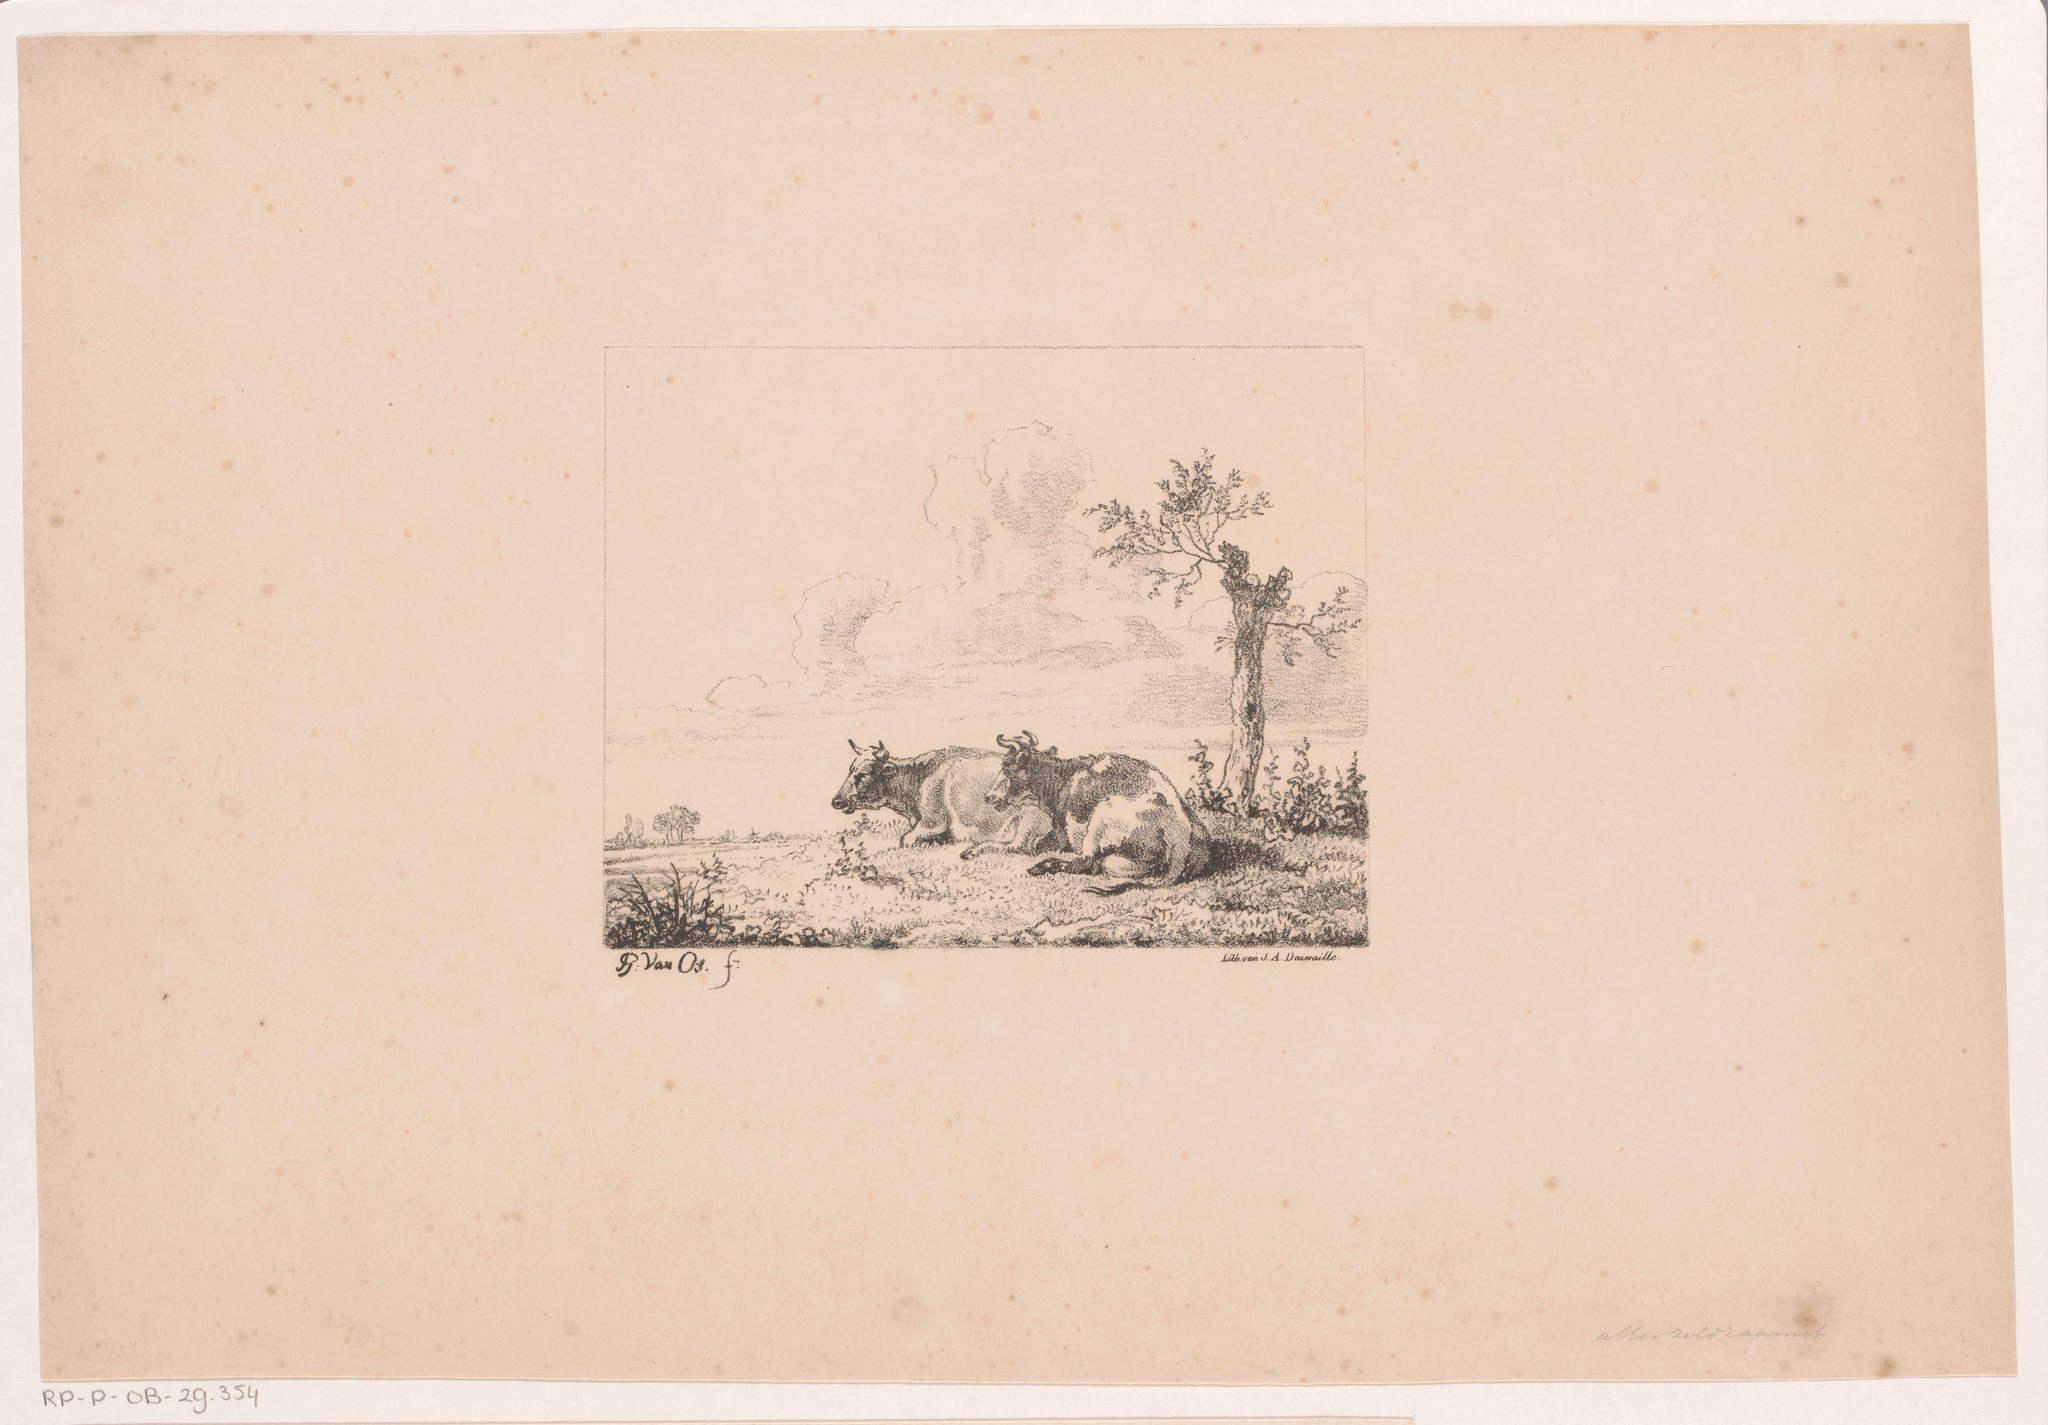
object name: print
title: Twee liggende koeien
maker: pieter gerardus van os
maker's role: draughtsman, painter, print maker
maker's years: 1776-1839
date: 1828-1830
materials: paper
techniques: lithograph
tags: cow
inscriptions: collector's mark: Lugt 2228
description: De koeien liggen in een weiland bij een boom.